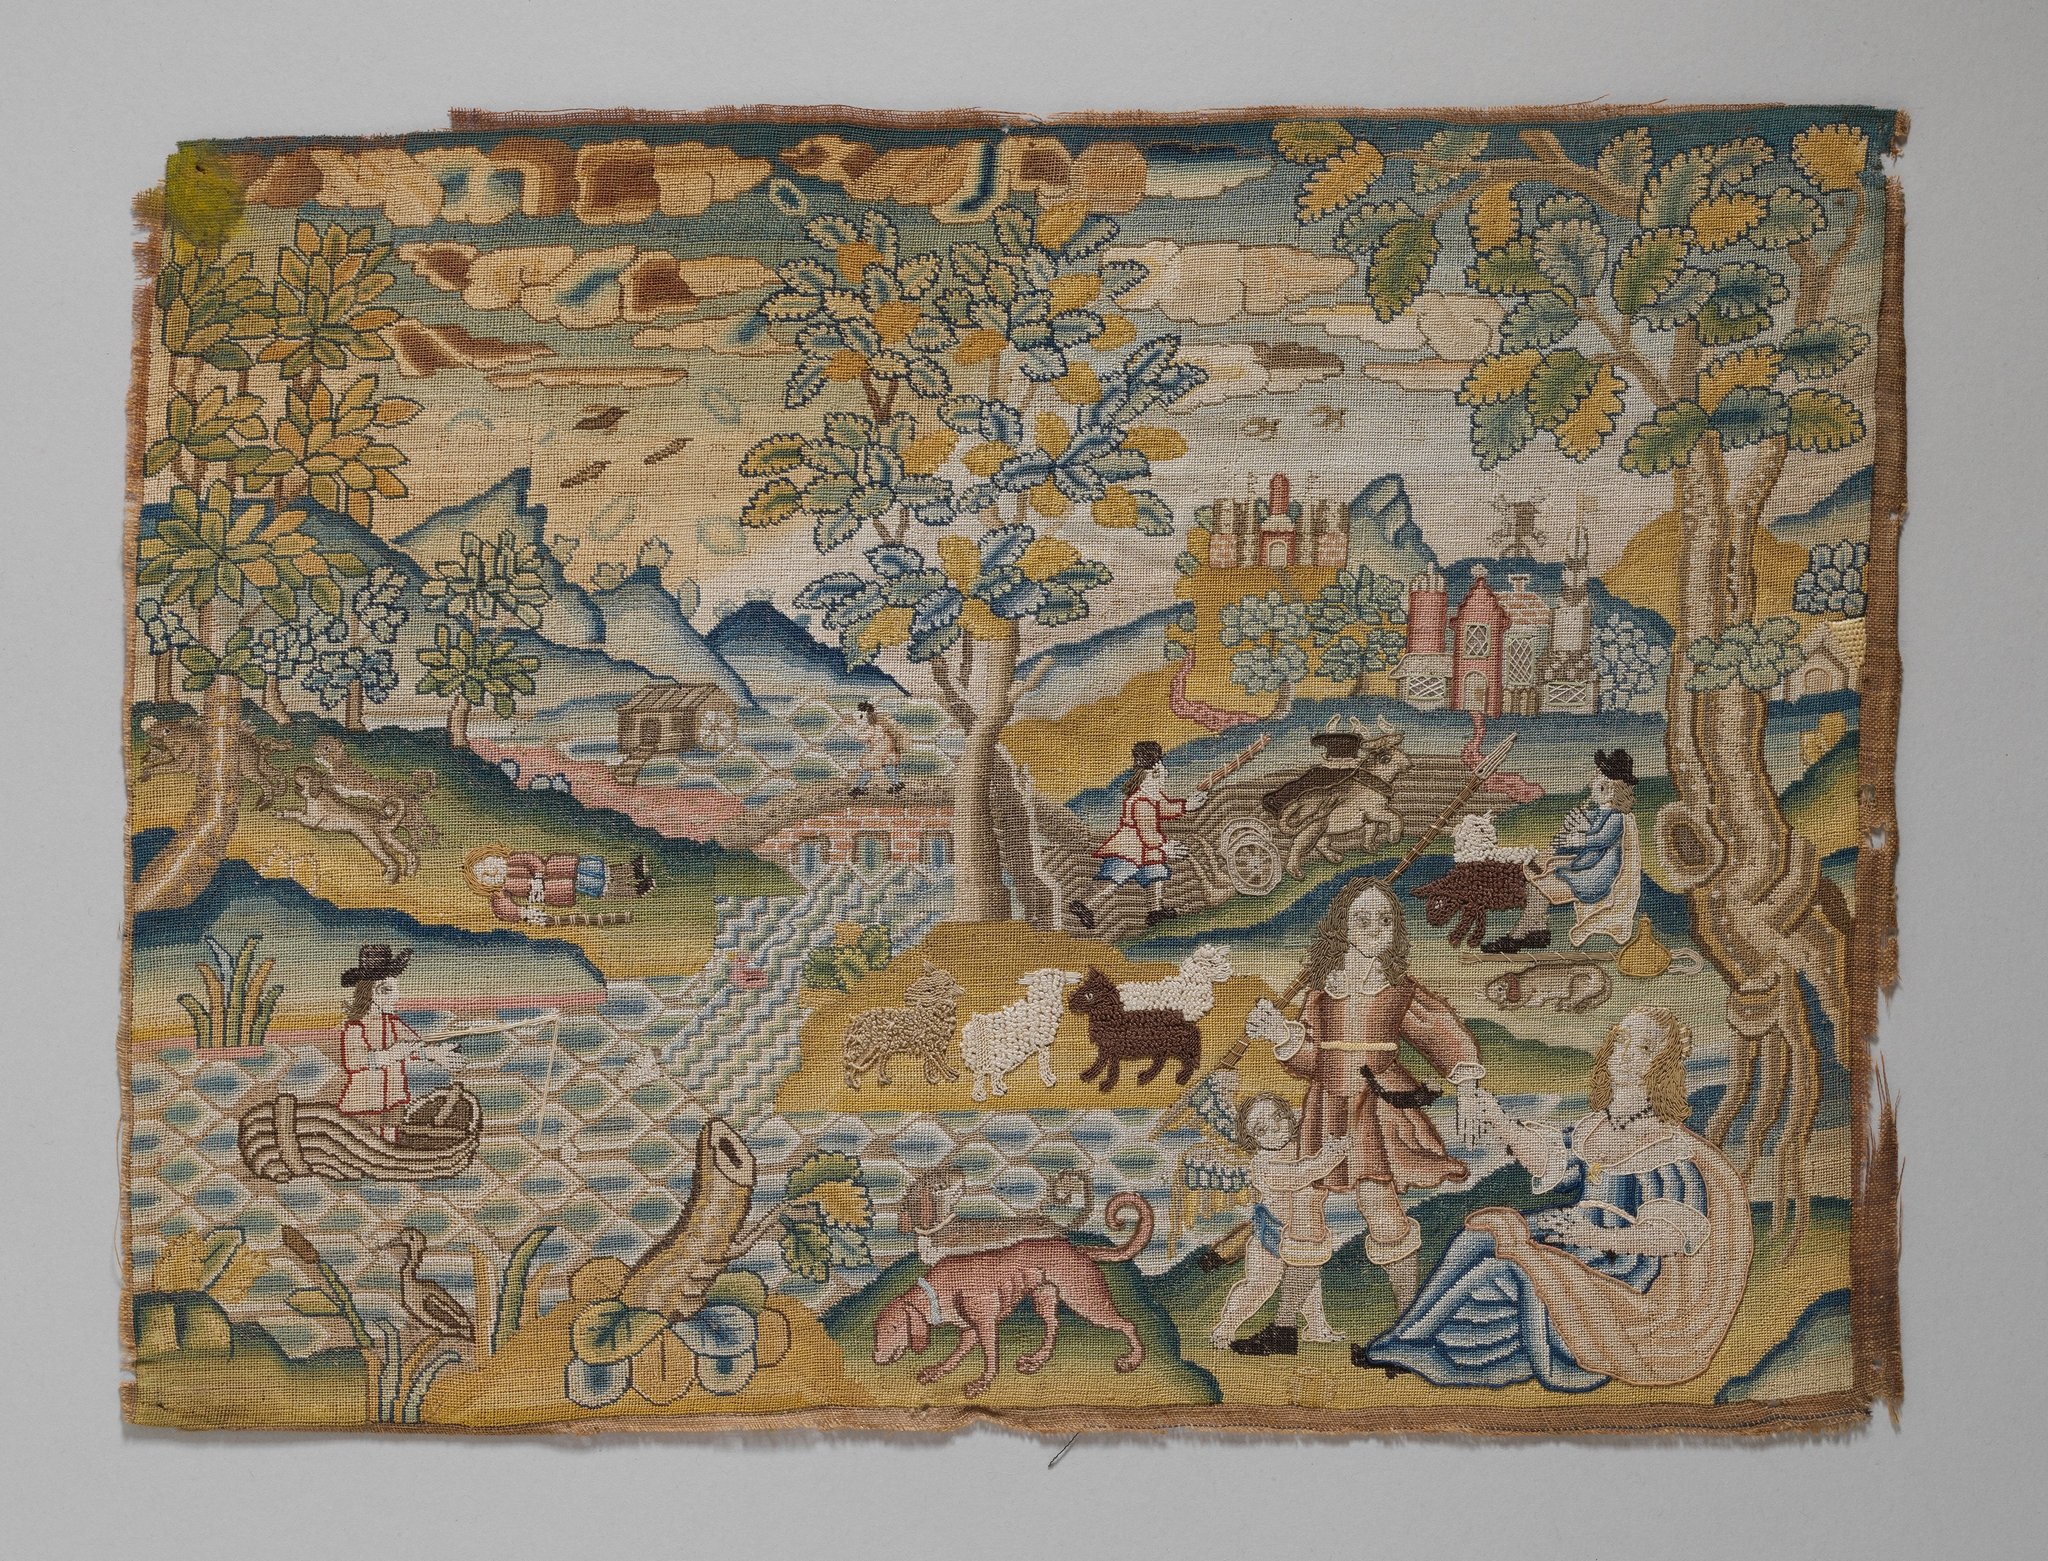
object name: embroidered picture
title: Lovers with Amor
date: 1634-1666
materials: brick, canvas, mica, thread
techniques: embroidery, stitching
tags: farms,men,women,fishing,dogs,rivers